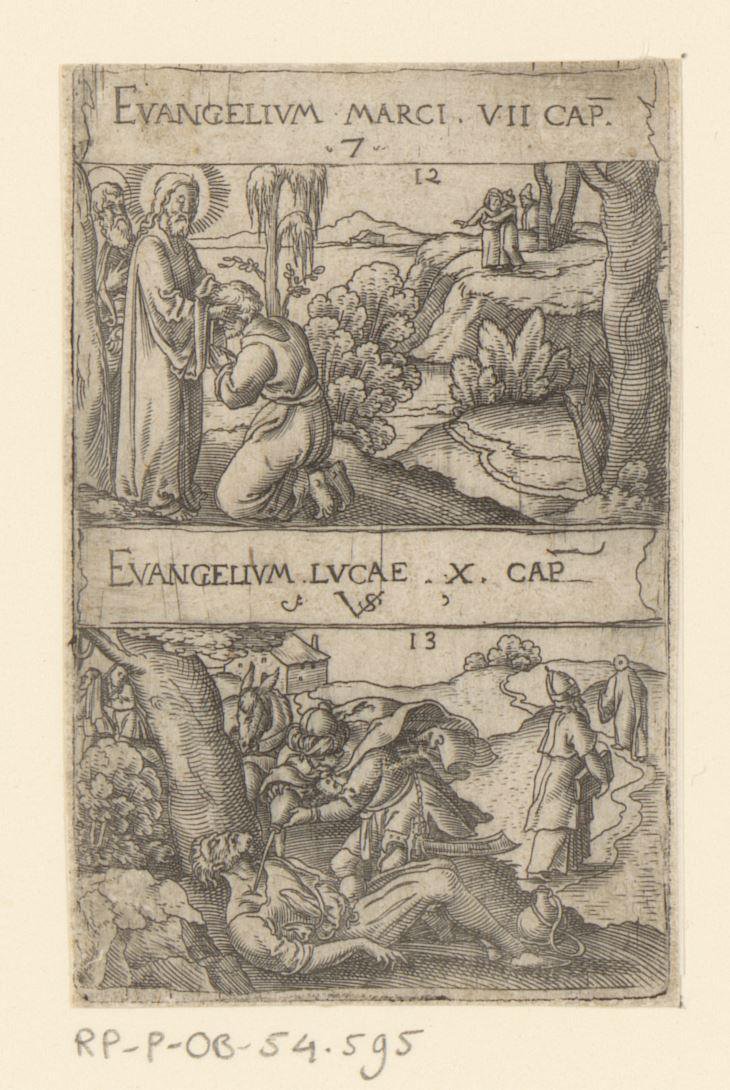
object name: print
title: Genezing door Christus van een doofstomme man en de barmhartige Samaritaan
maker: virgilius solis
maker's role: draughtsman, print maker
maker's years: 1514-1562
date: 1524-1562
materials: paper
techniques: engraving, etching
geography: nuremberg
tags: healing of a deaf man in decapolis (mark 7:31-37), deaf, deafness, the good samaritan (luke 10:30-37)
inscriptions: collector's mark: Lugt 2228, number: ‘88’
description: Voorstellingen naar beschrijvingen van de Barmhartige Samaritaan in Lucas 10:30-37 en een genezing in Marcus 7:32. Dit is in de Statenvertaling beschreven als: “En zij brachten tot Hem een dove, die zwaarlijk sprak, en baden Hem, dat Hij de hand op hem legde.”In de Nieuwe Bijbelvertaling 21 staat: “Daar werd iemand bij Hem gebracht die doof was en gebrekkig sprak, en men smeekte Hem om deze man de hand op te leggen.” Twee voorstellingen boven elkaar. De prent is genummerd midden boven: 7. De voorstellingen zijn afzonderlijk genummerd: 12 en 13.